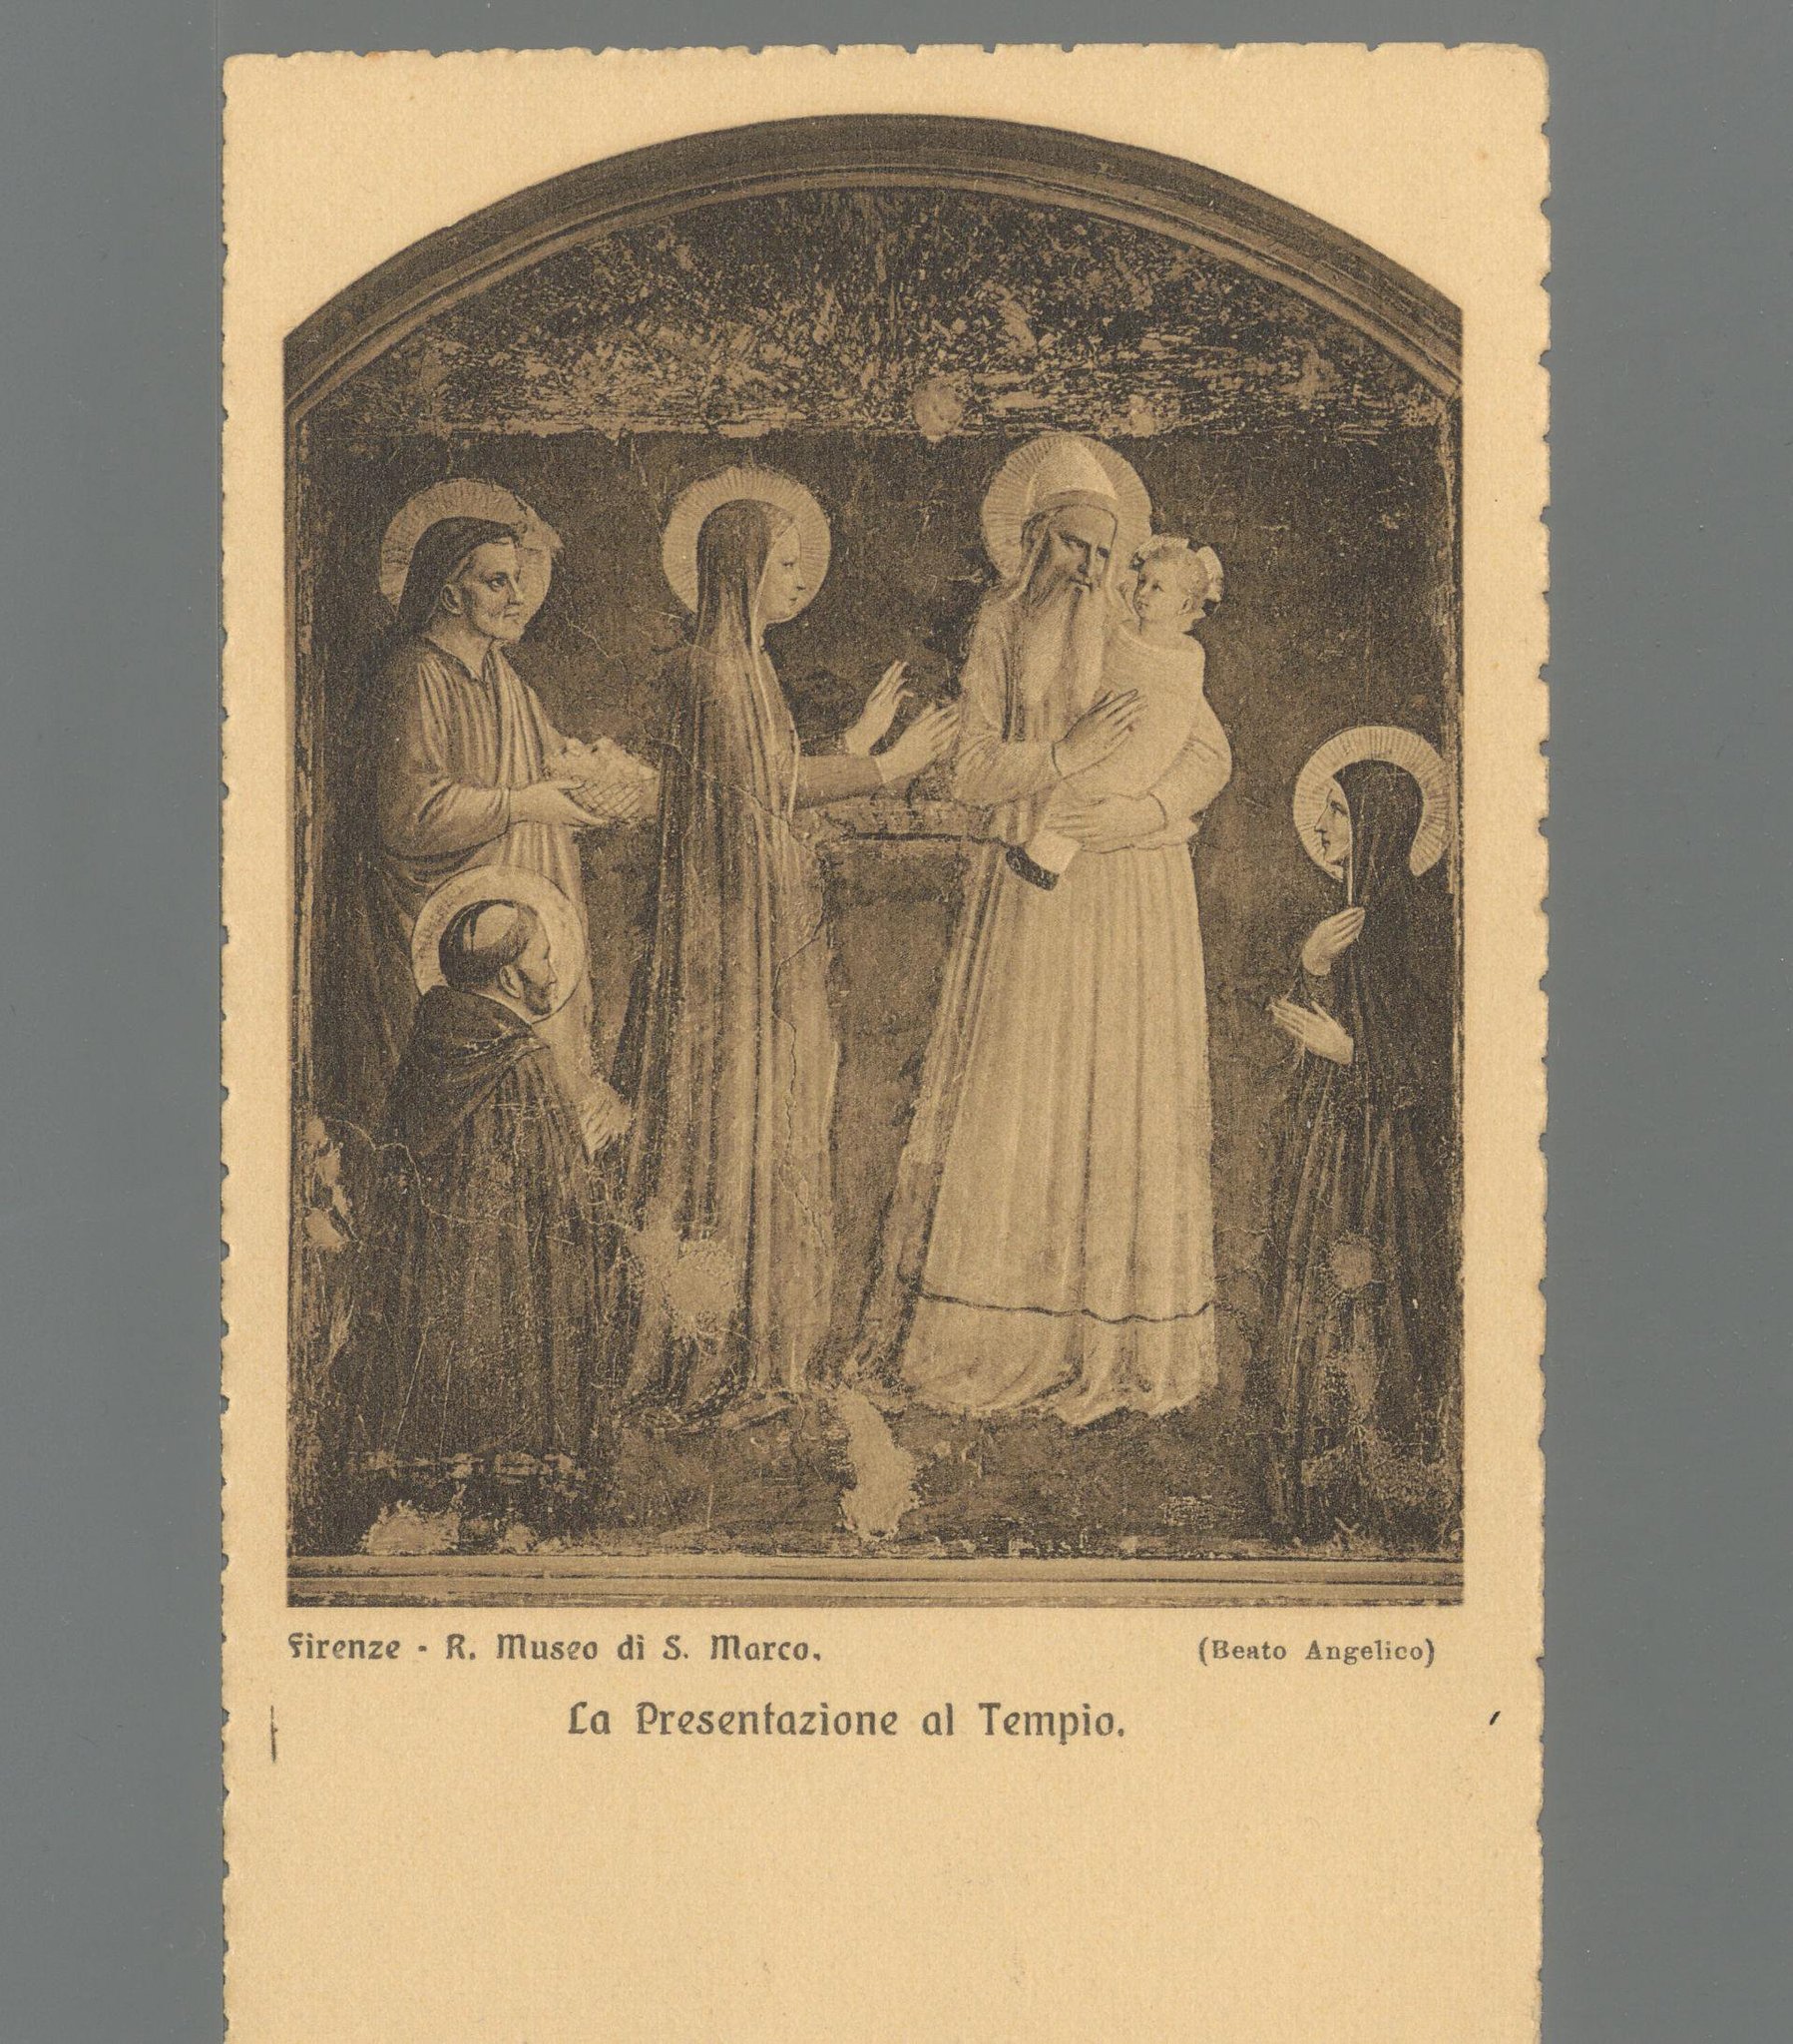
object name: reproduction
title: Firenze - R. Museo di S. Marco. La Presentazione al Tempio (Beato Angelico)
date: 1906-1930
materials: cardboard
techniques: photograph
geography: como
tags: permanent exhibition, museum, picture, painting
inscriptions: collector's mark: ‘AFE v S’